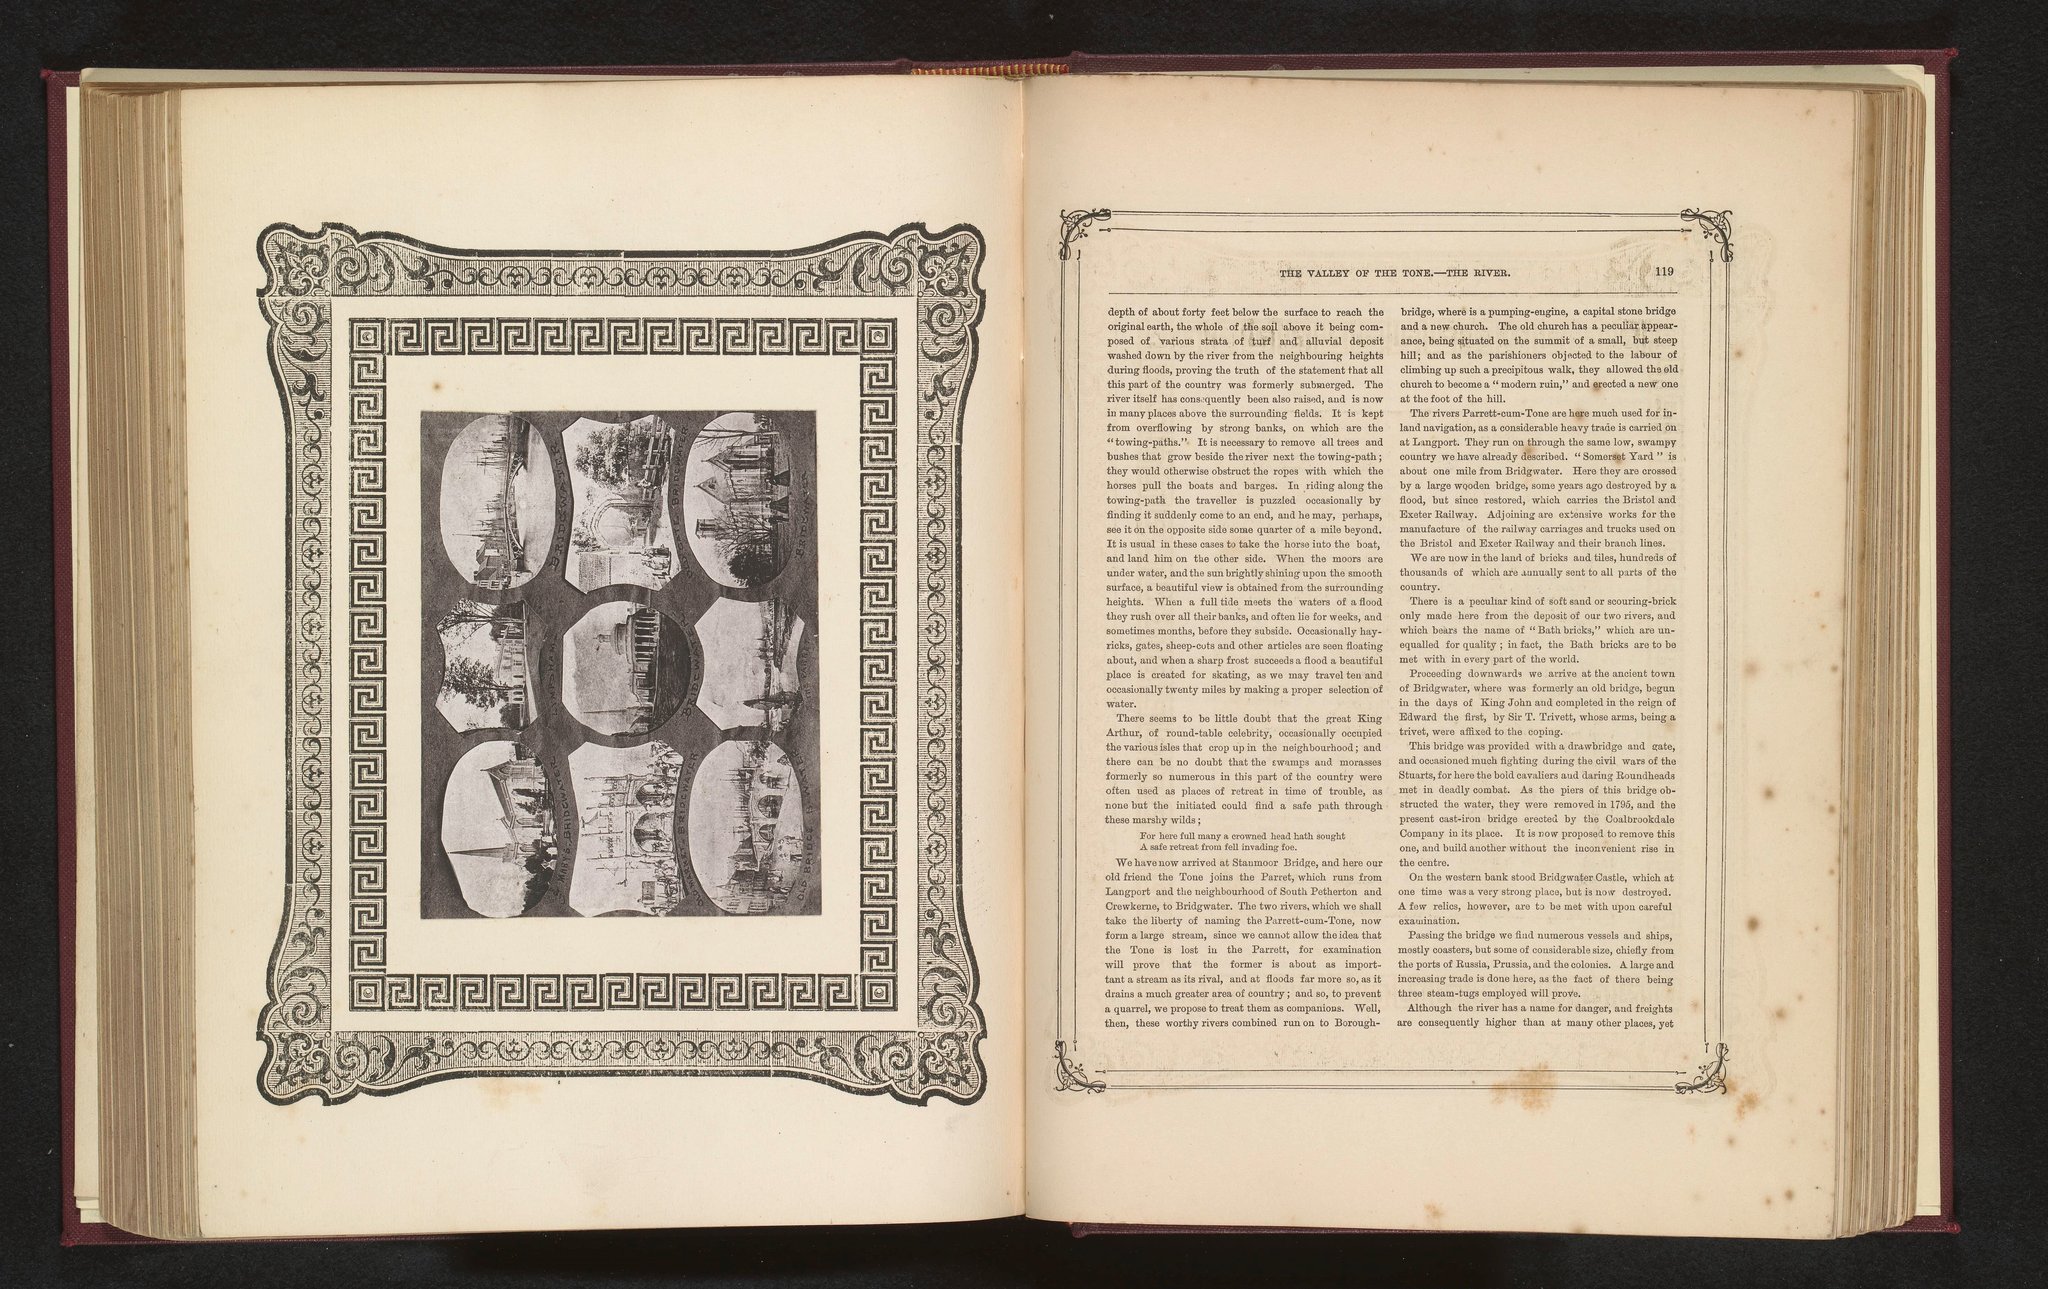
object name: photomechanical print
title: Negen gezichten op gebouwen en bruggen in West Dorset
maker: Anonymous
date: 1868-1873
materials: paper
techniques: photoaquatint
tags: church (exterior), exterior ~ representation of a building, bridge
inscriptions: inscription: ‘St Mary Bridgwater (...) Bridgwater’